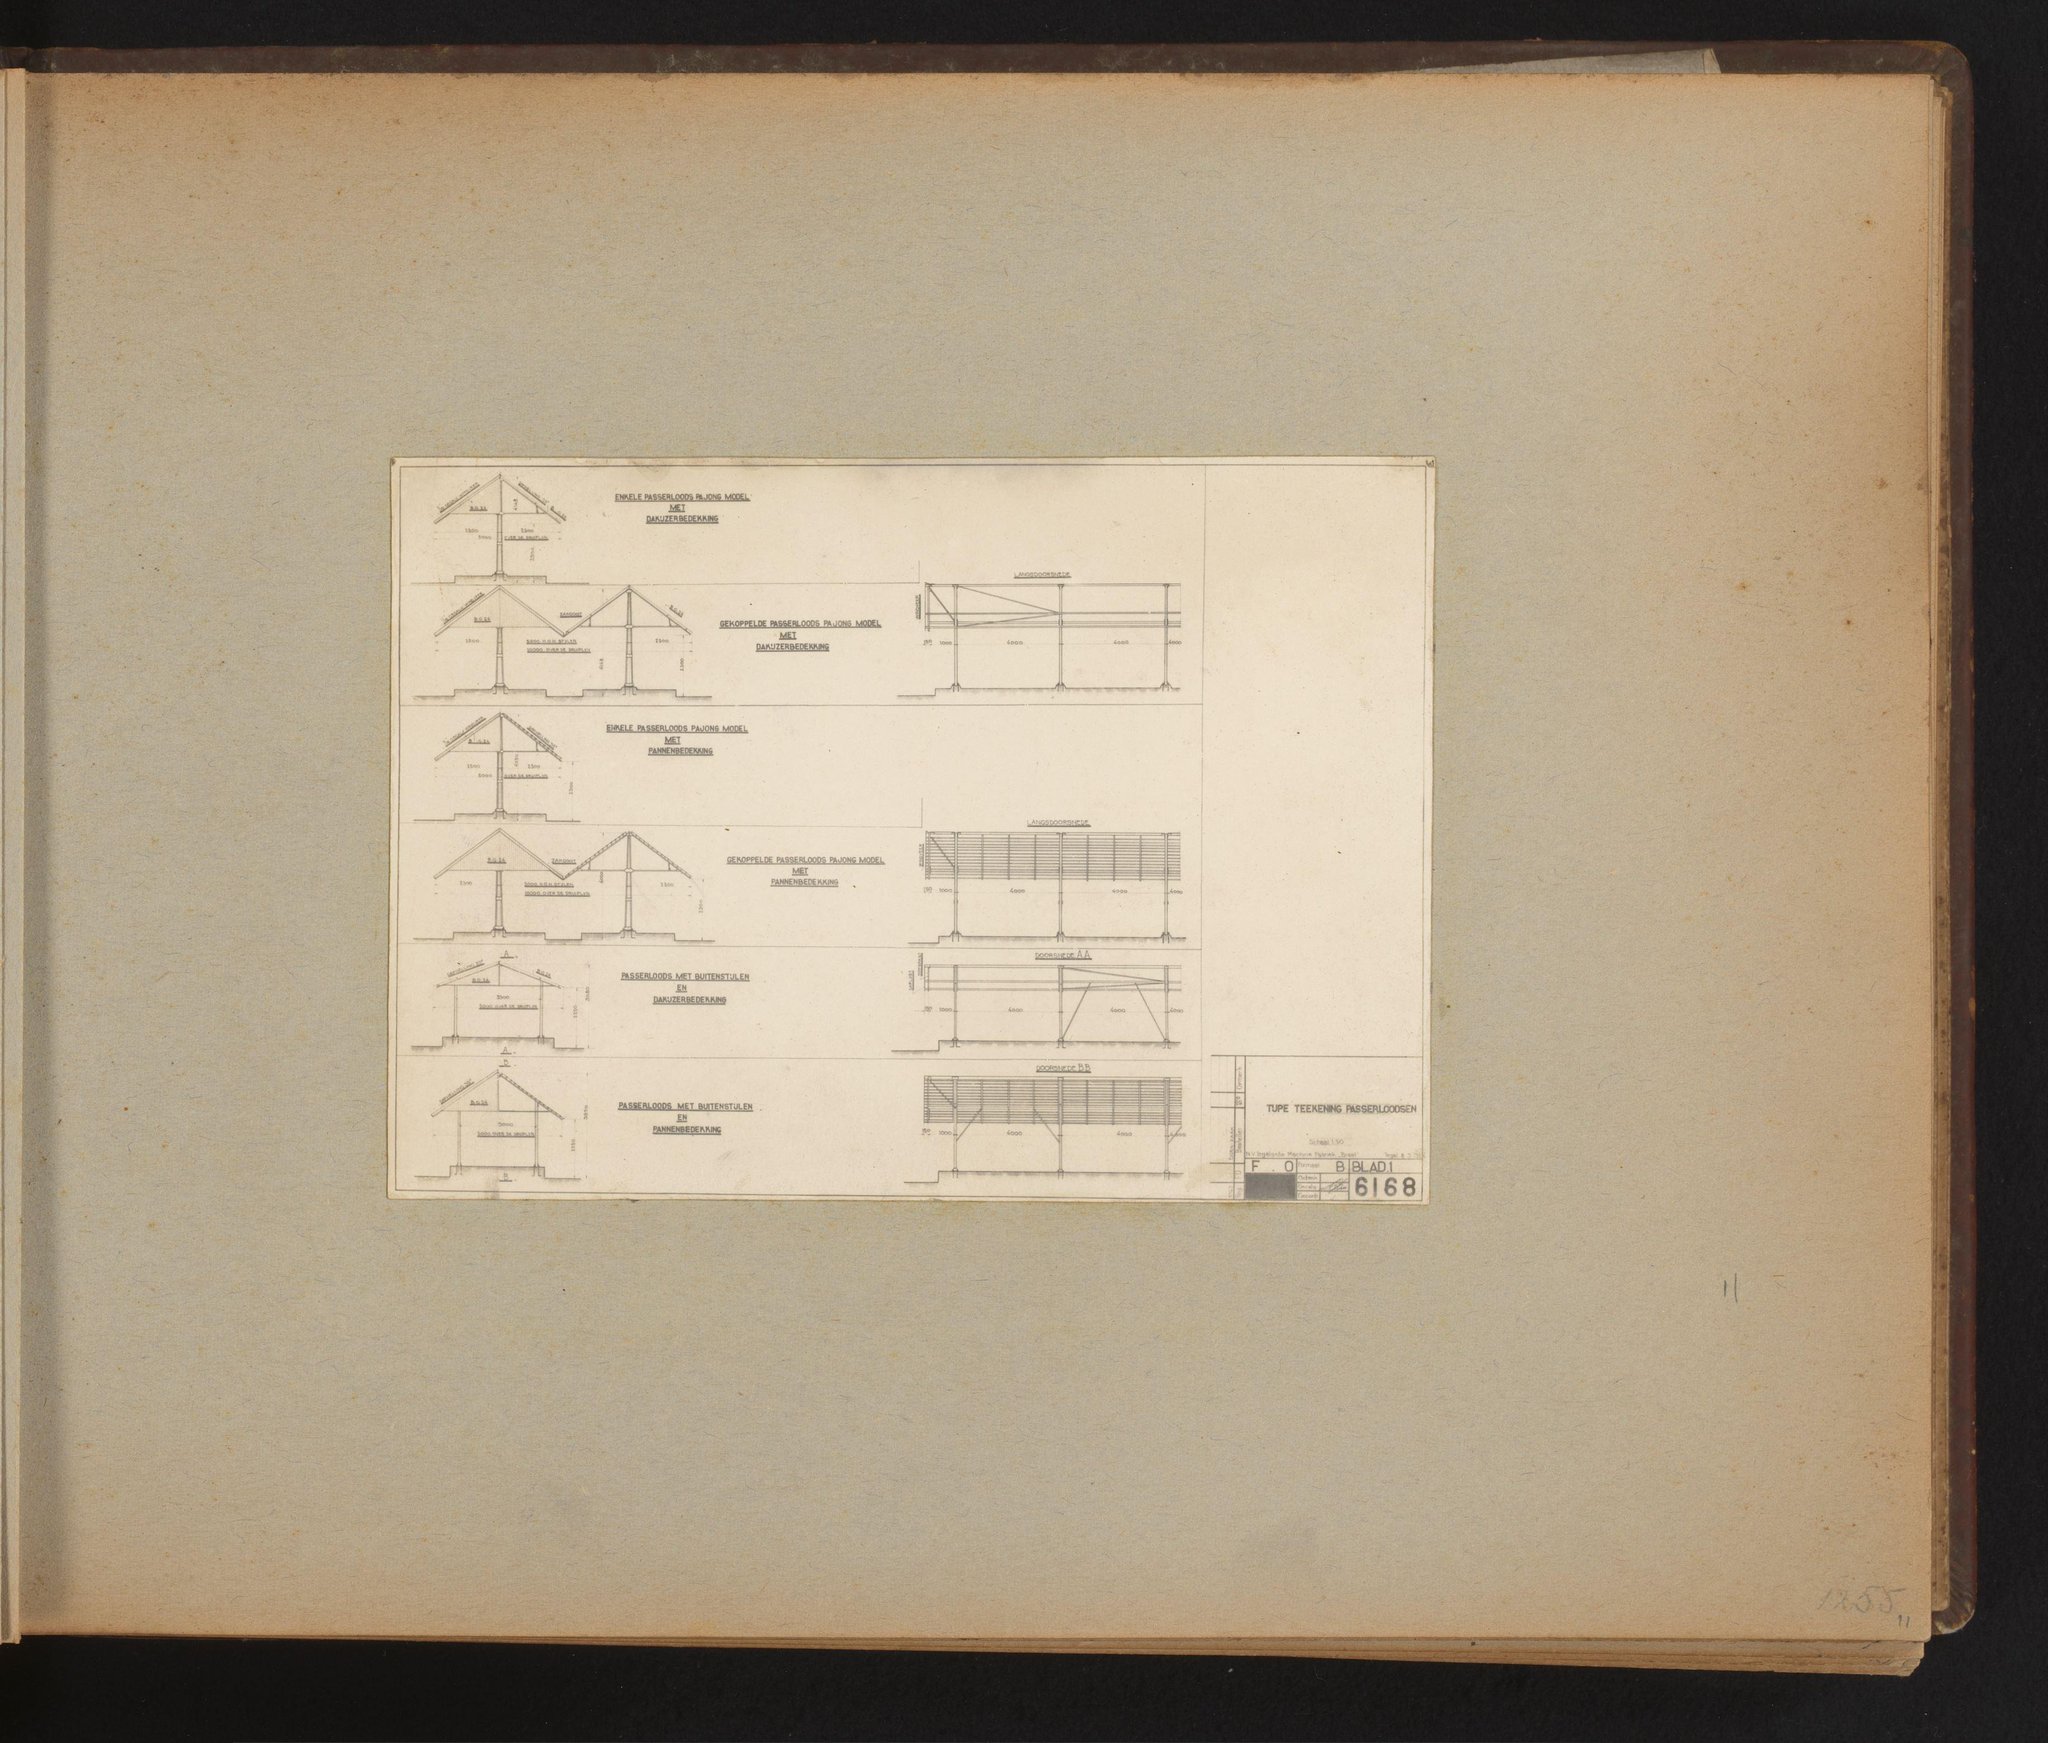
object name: album leaf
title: Technische tekeningen voor de constructie van een passerloods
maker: Anonymous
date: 1932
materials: cardboard, paper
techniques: reprographic copy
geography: tegal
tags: making the overground structures (~ building activities), plan ~ architecture, java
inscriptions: date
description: Albumblad met een reprografische kopie van een blad met technische tekeningen voor de constructie van een passerloods, vervaardigd in 1932 door de N.V. Tegalsche Machine Fabriek Braat. Onderdeel van een fotoalbum met foto's van machines en constructies van de N.V. Machinefabriek Braat te Soerabaja, Soekaboemi en Tegal uit de periode 1931-1937.